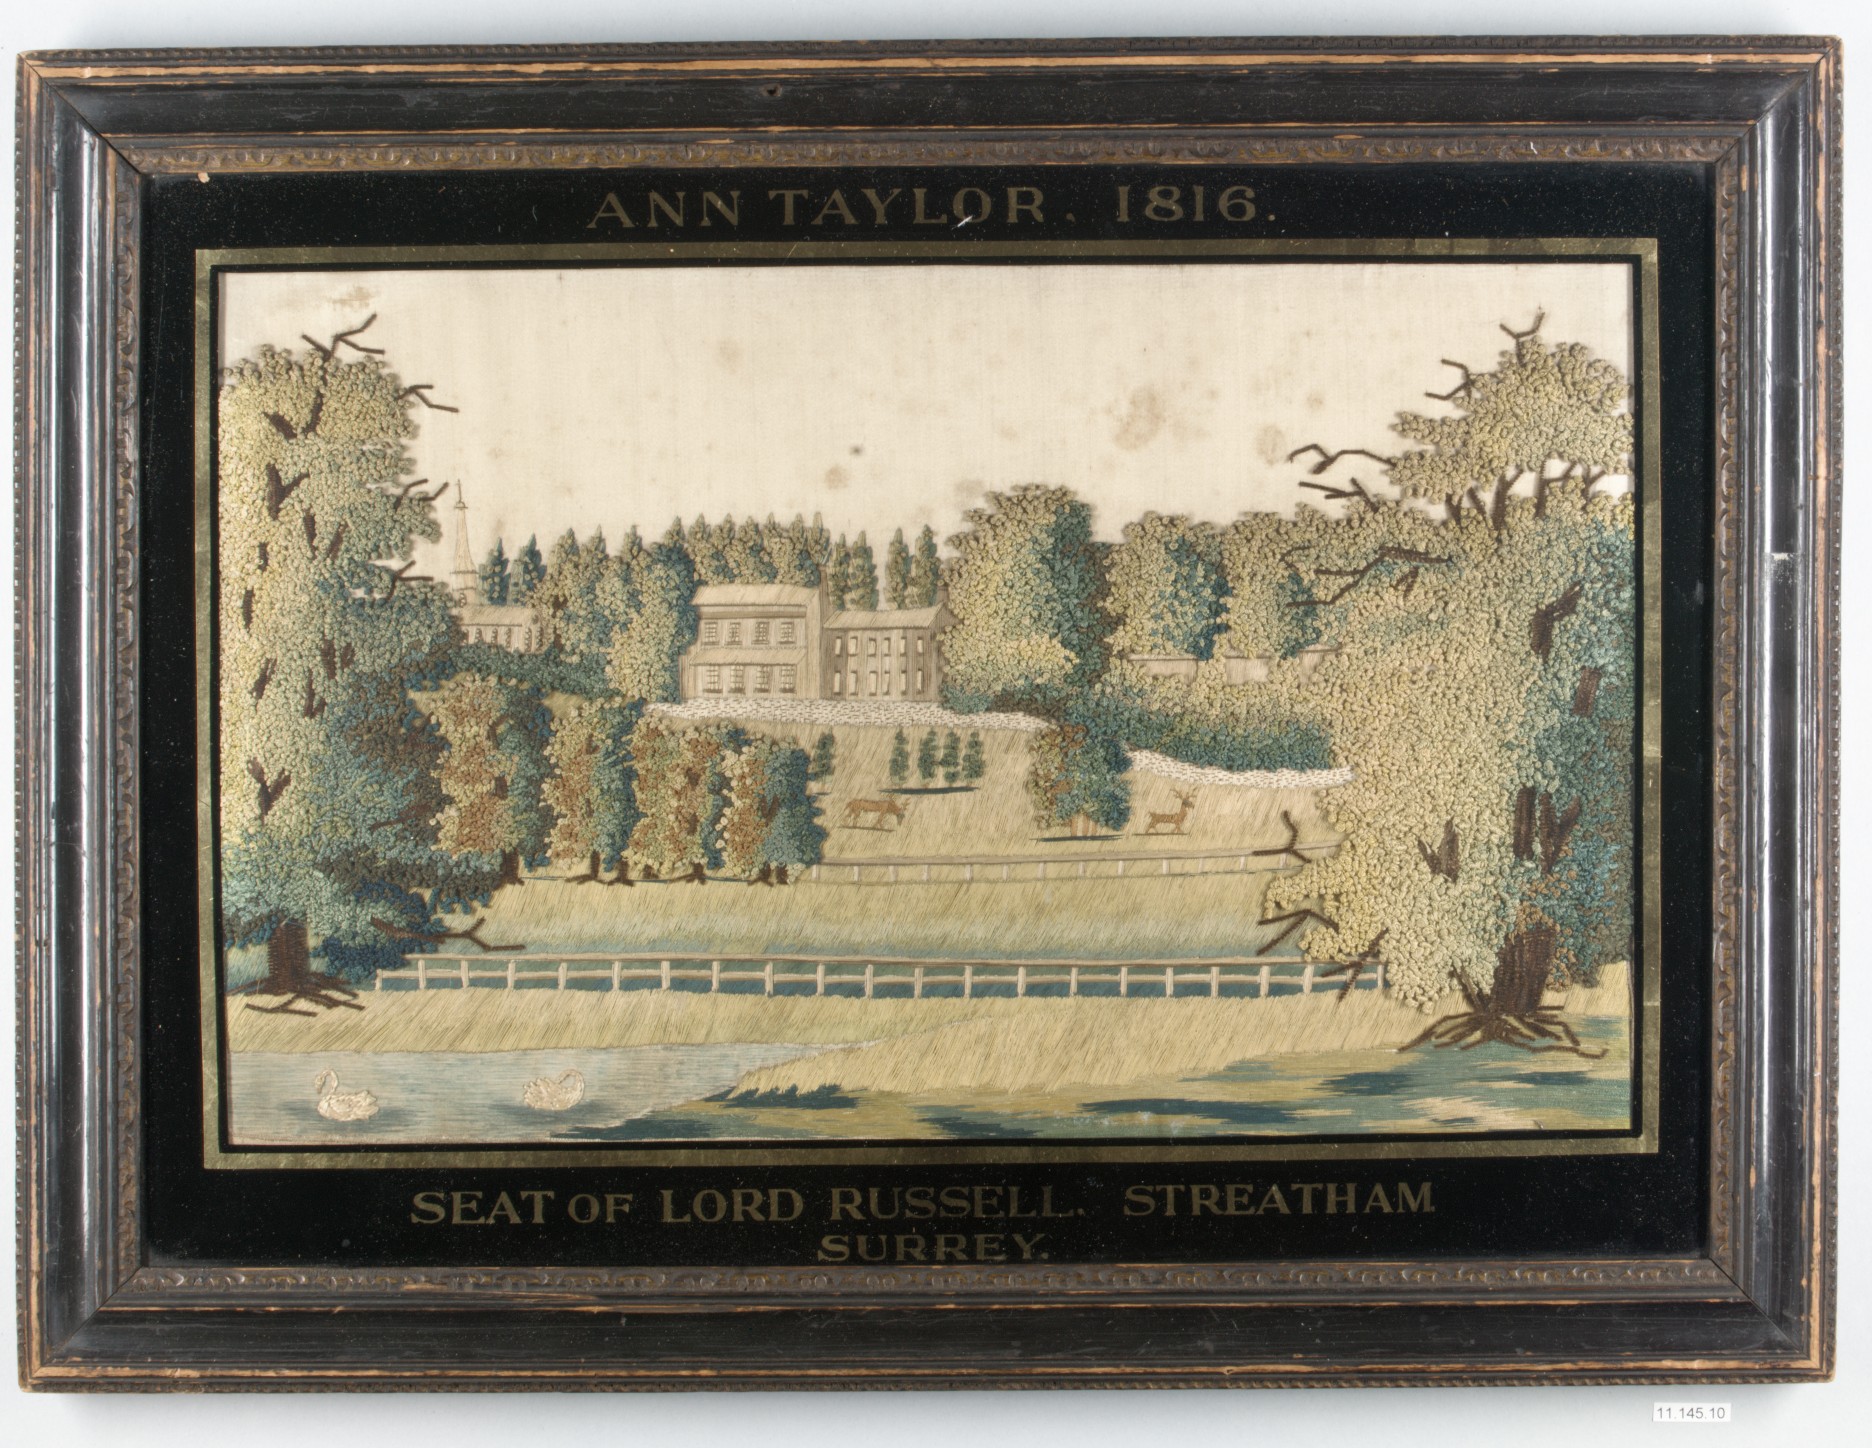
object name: embroidered picture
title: Seat of Lord Russell, Streatham, Surrey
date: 1816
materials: silk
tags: houses,swans,deer,trees